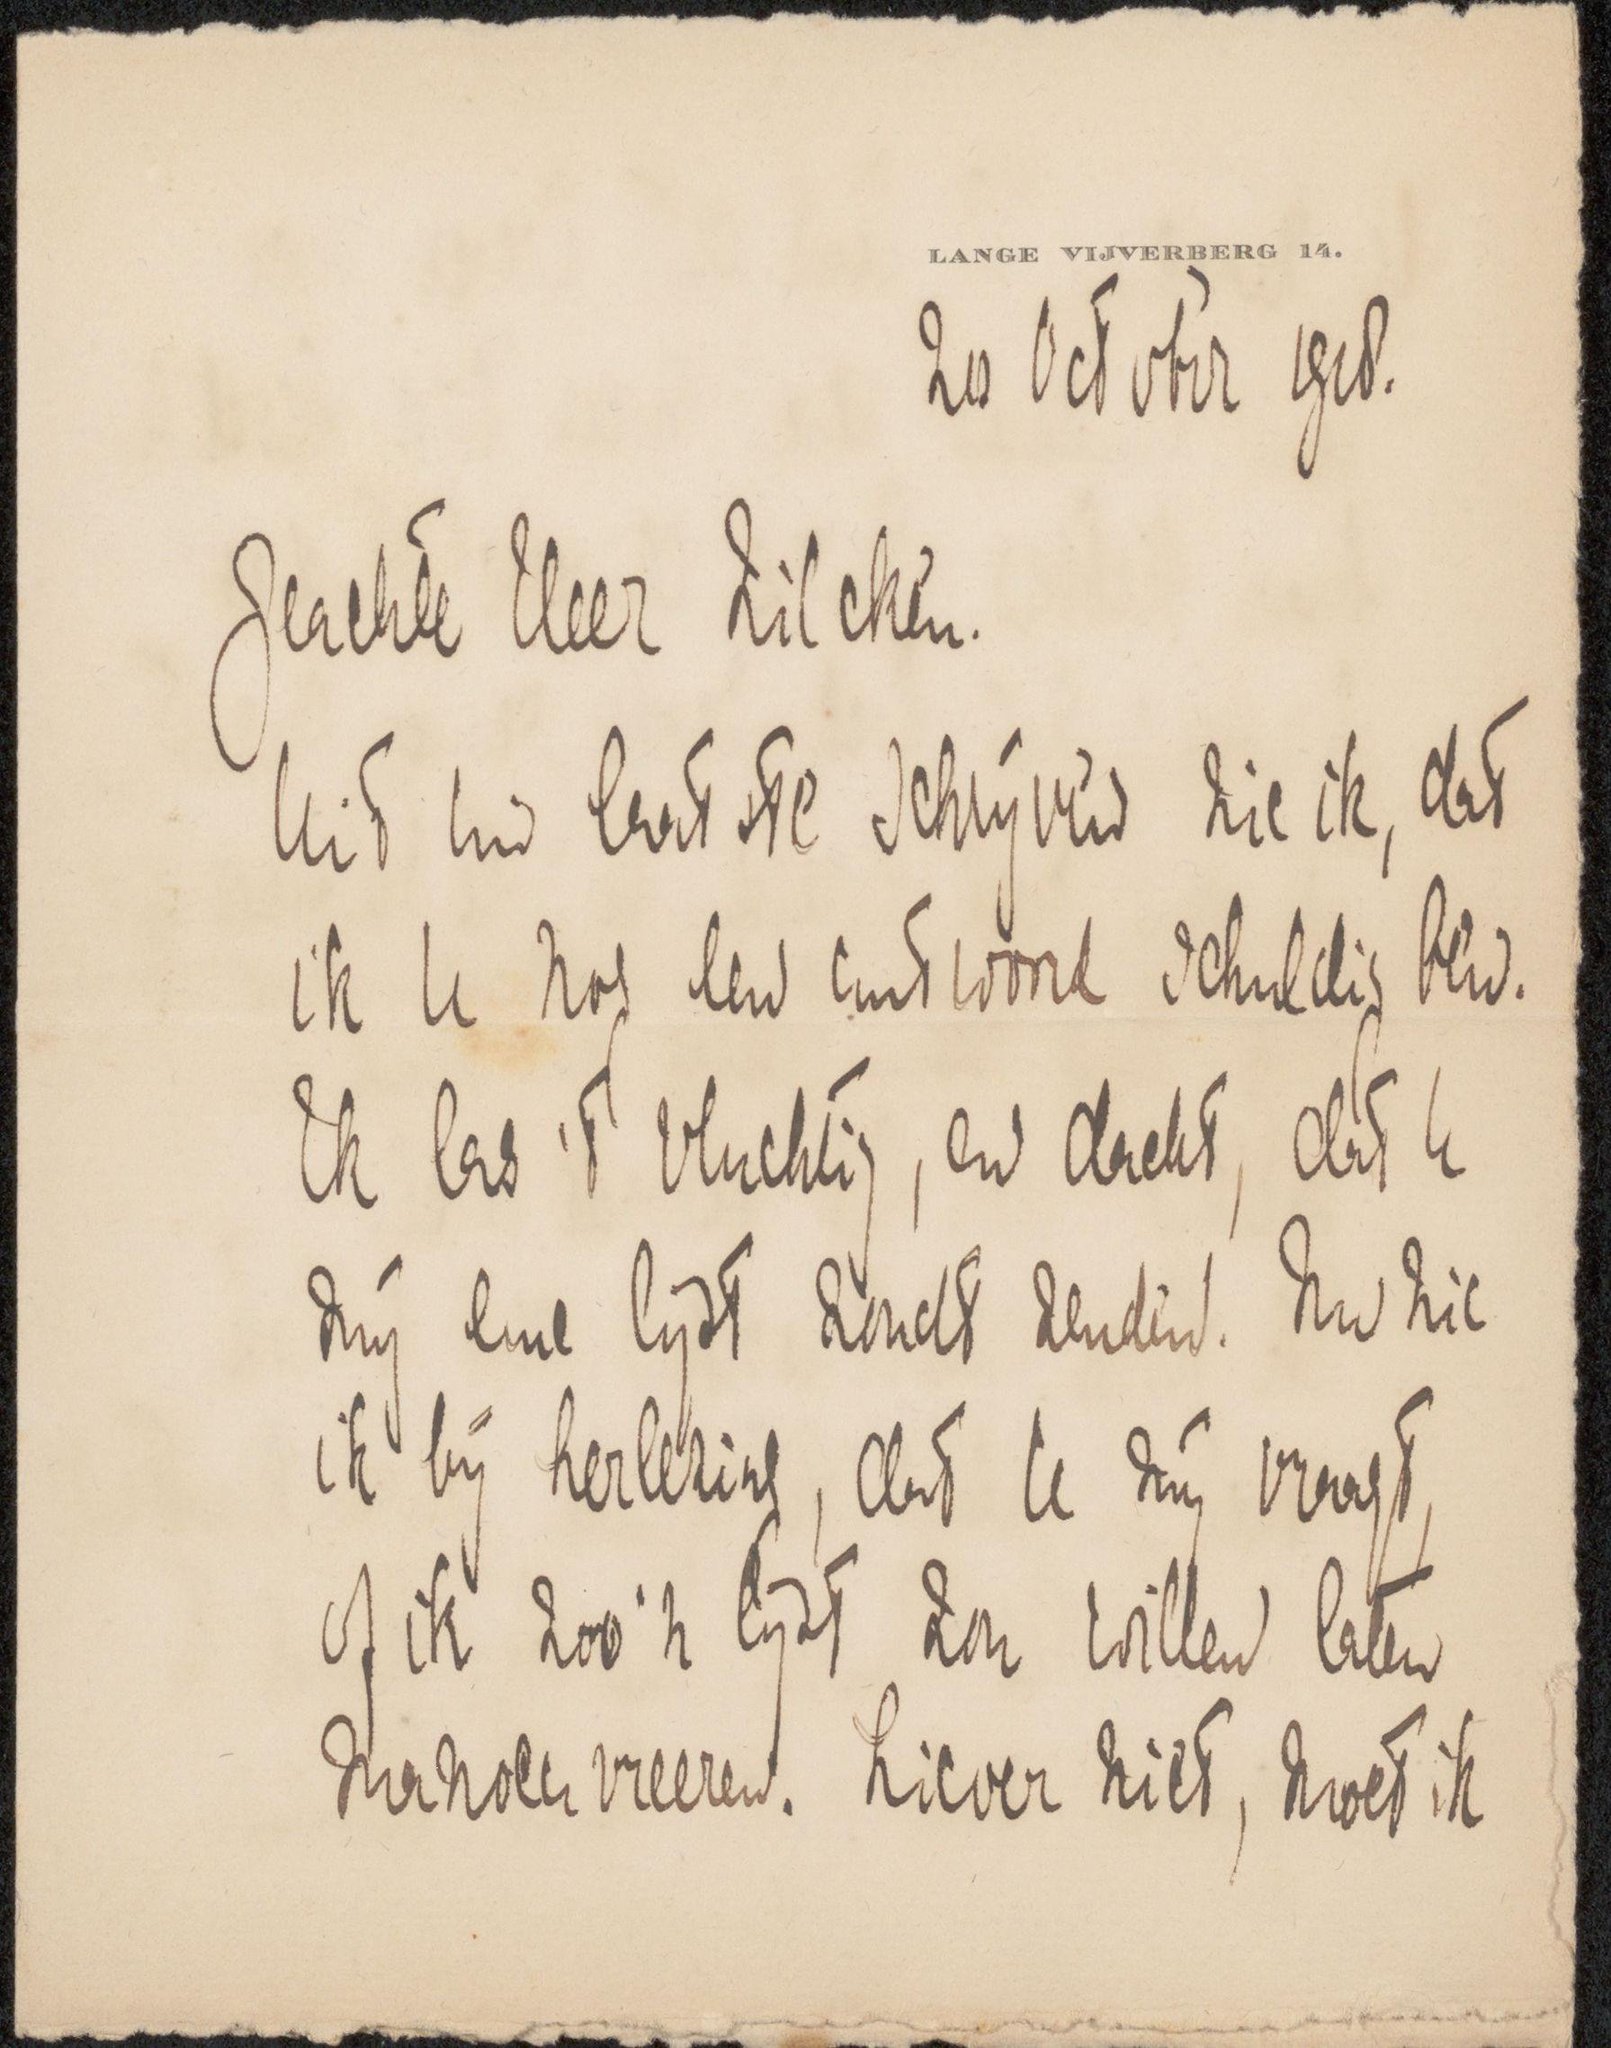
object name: letter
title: Brief aan Philip Zilcken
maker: r. cremers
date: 1908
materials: ink, paper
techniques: pen, printing, writing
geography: the hague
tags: the hague, draughtsman, philip zilcken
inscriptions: collector's mark: ‘RPK’, watermark